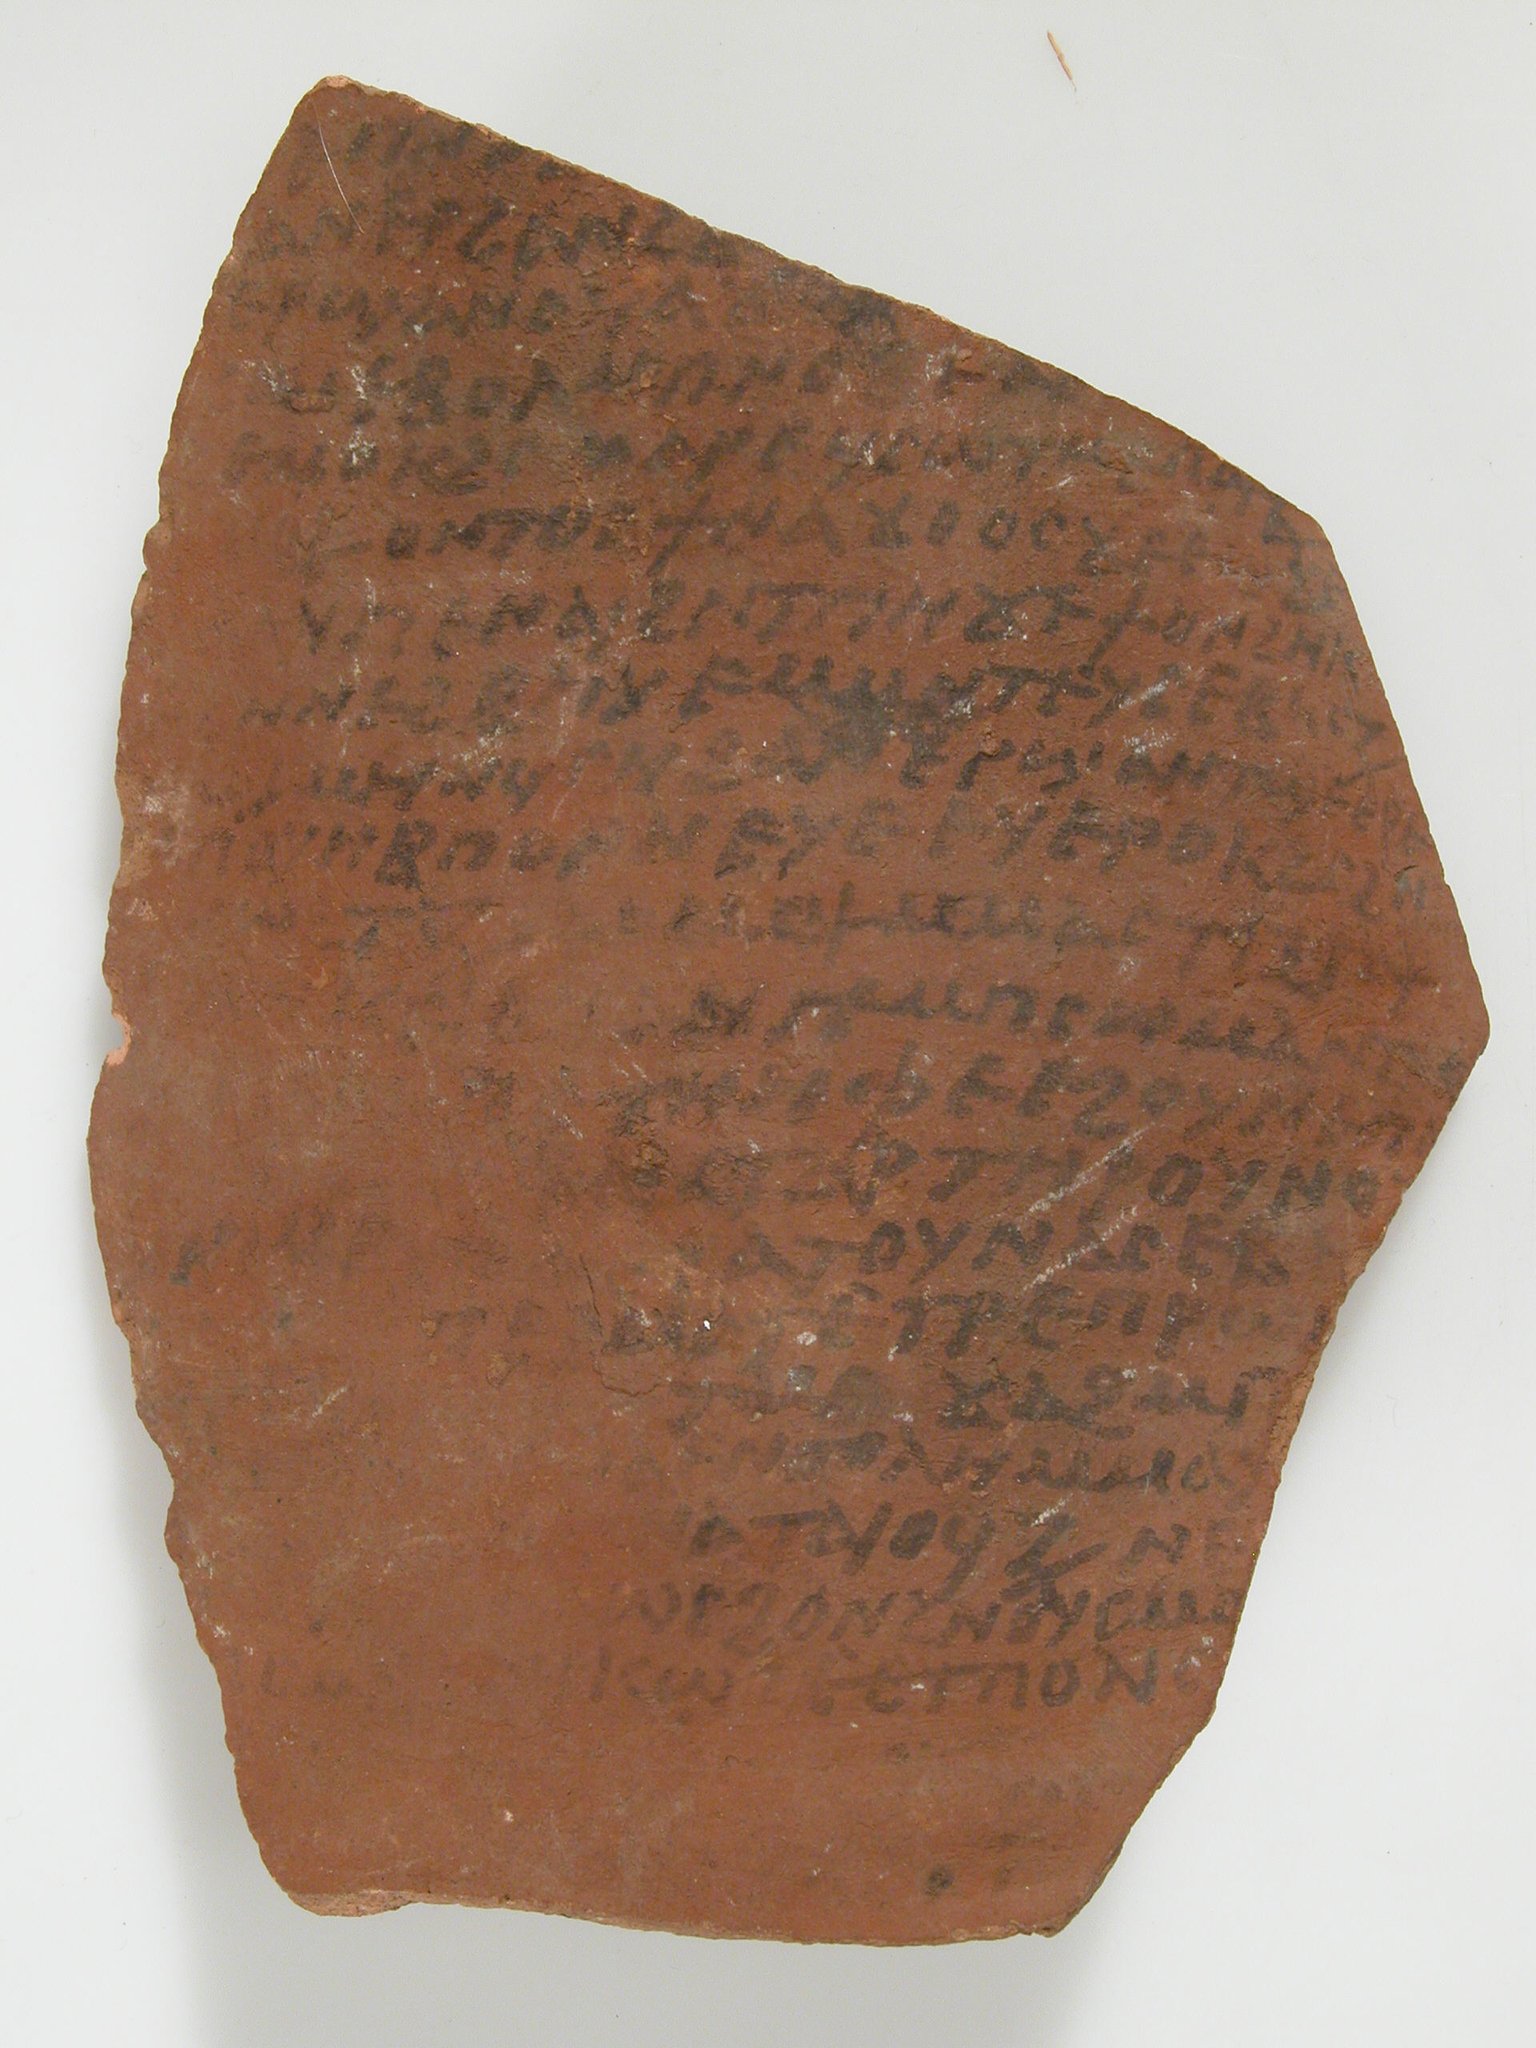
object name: ostrakon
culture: coptic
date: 601-700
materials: ink, pottery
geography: egypt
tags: documents